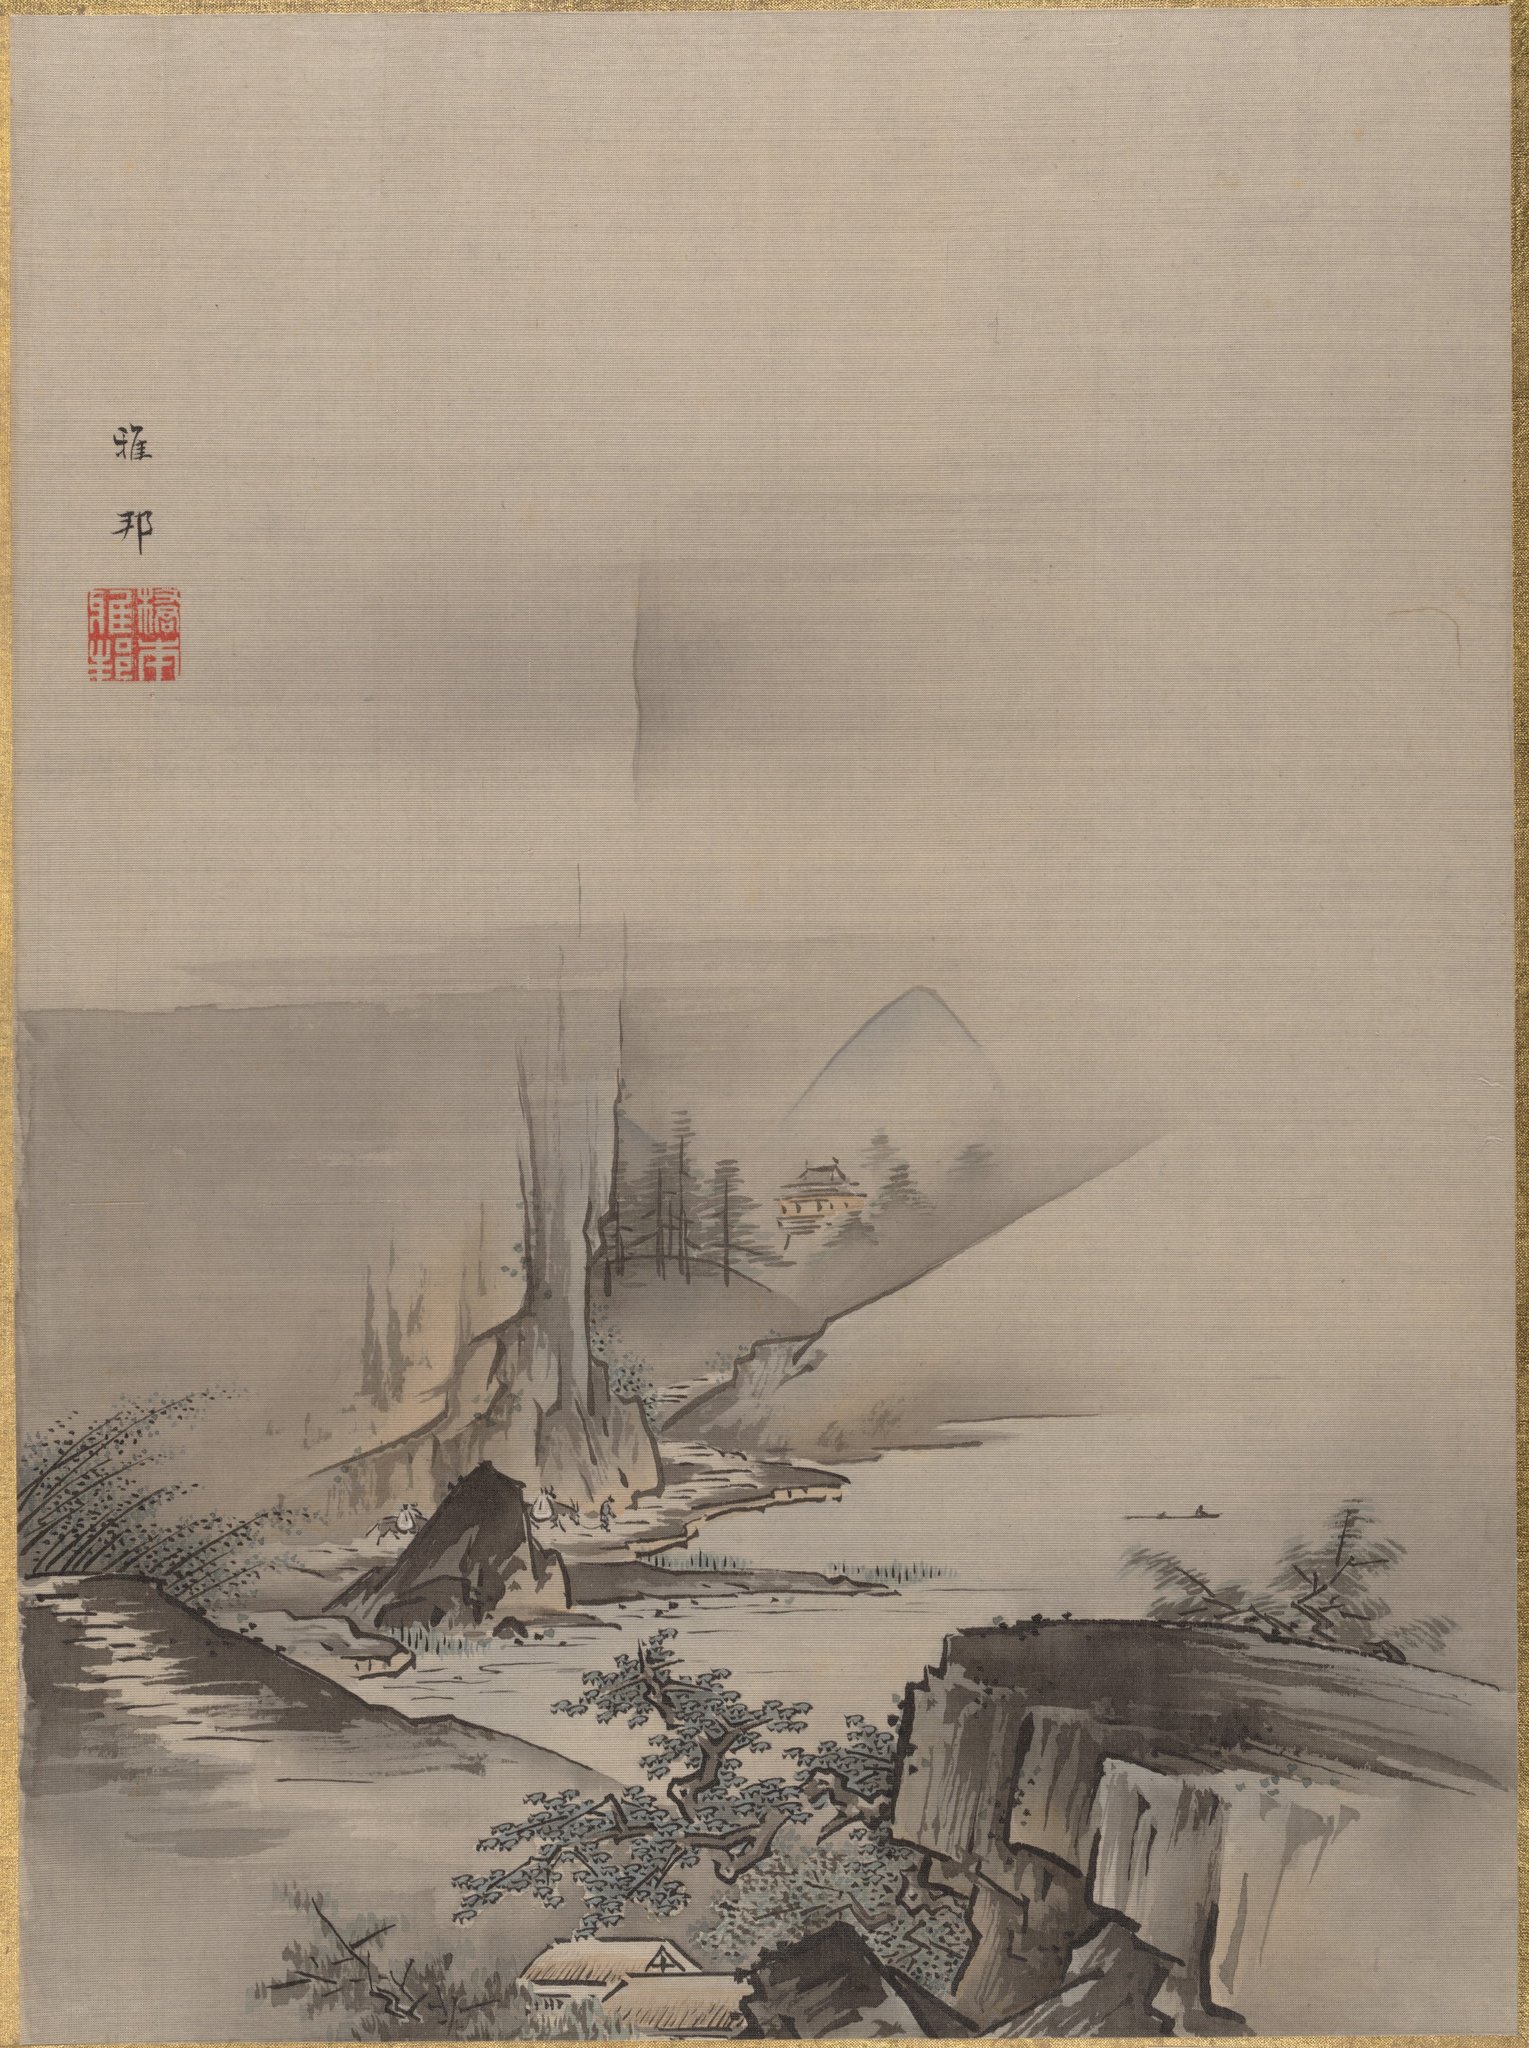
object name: album leaf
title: Rapids and Fall of a River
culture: japanese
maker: hashimoto gahō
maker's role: artist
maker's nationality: japanese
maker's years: 1835-1908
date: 1868-1912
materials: ink, silk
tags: rivers,mountains,landscapes